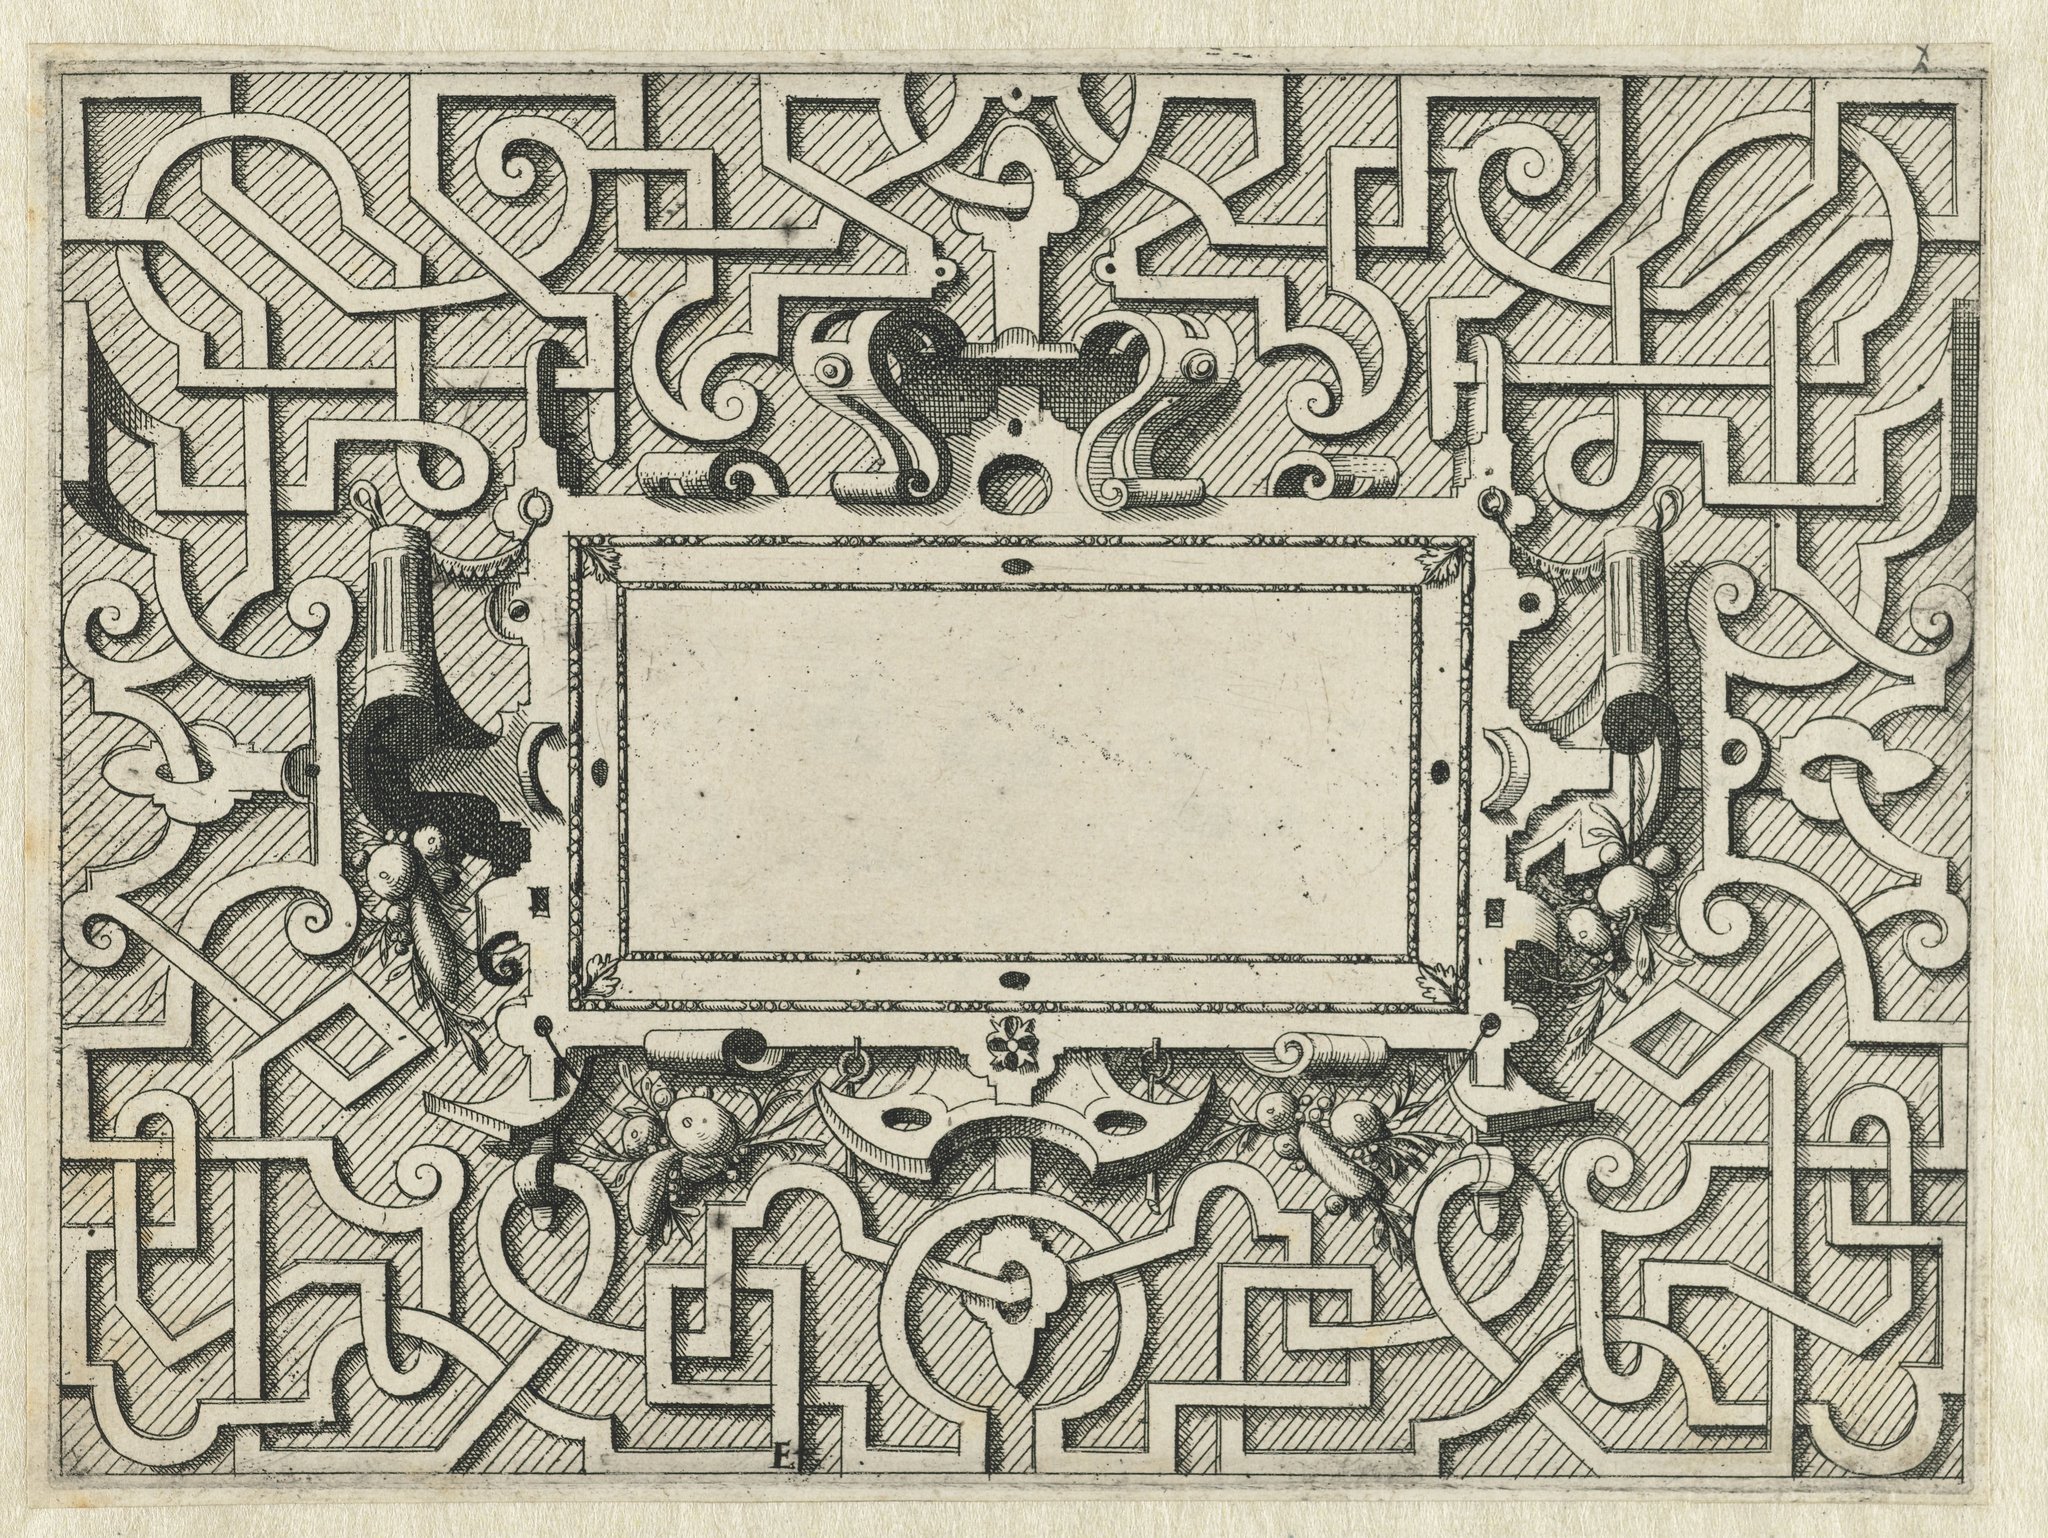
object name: print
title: Cartouches in een omlijsting van rol- en beslagwerk met grotesken, moresken, guirlandes, mascarons en trofeeën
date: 1555-1560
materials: paper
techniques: etching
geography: netherlands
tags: ornament ~ moresque, ornament ~ cartouche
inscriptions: inscription: ‘.’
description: Gearceerde achtergrond. Langs de onderrand van de cartouche hangen guirlandes met vruchtentrossen. Blad E uit serie van 16 bladen, geletterd A-Q. Gearceerde of gestippelde achtergrond.